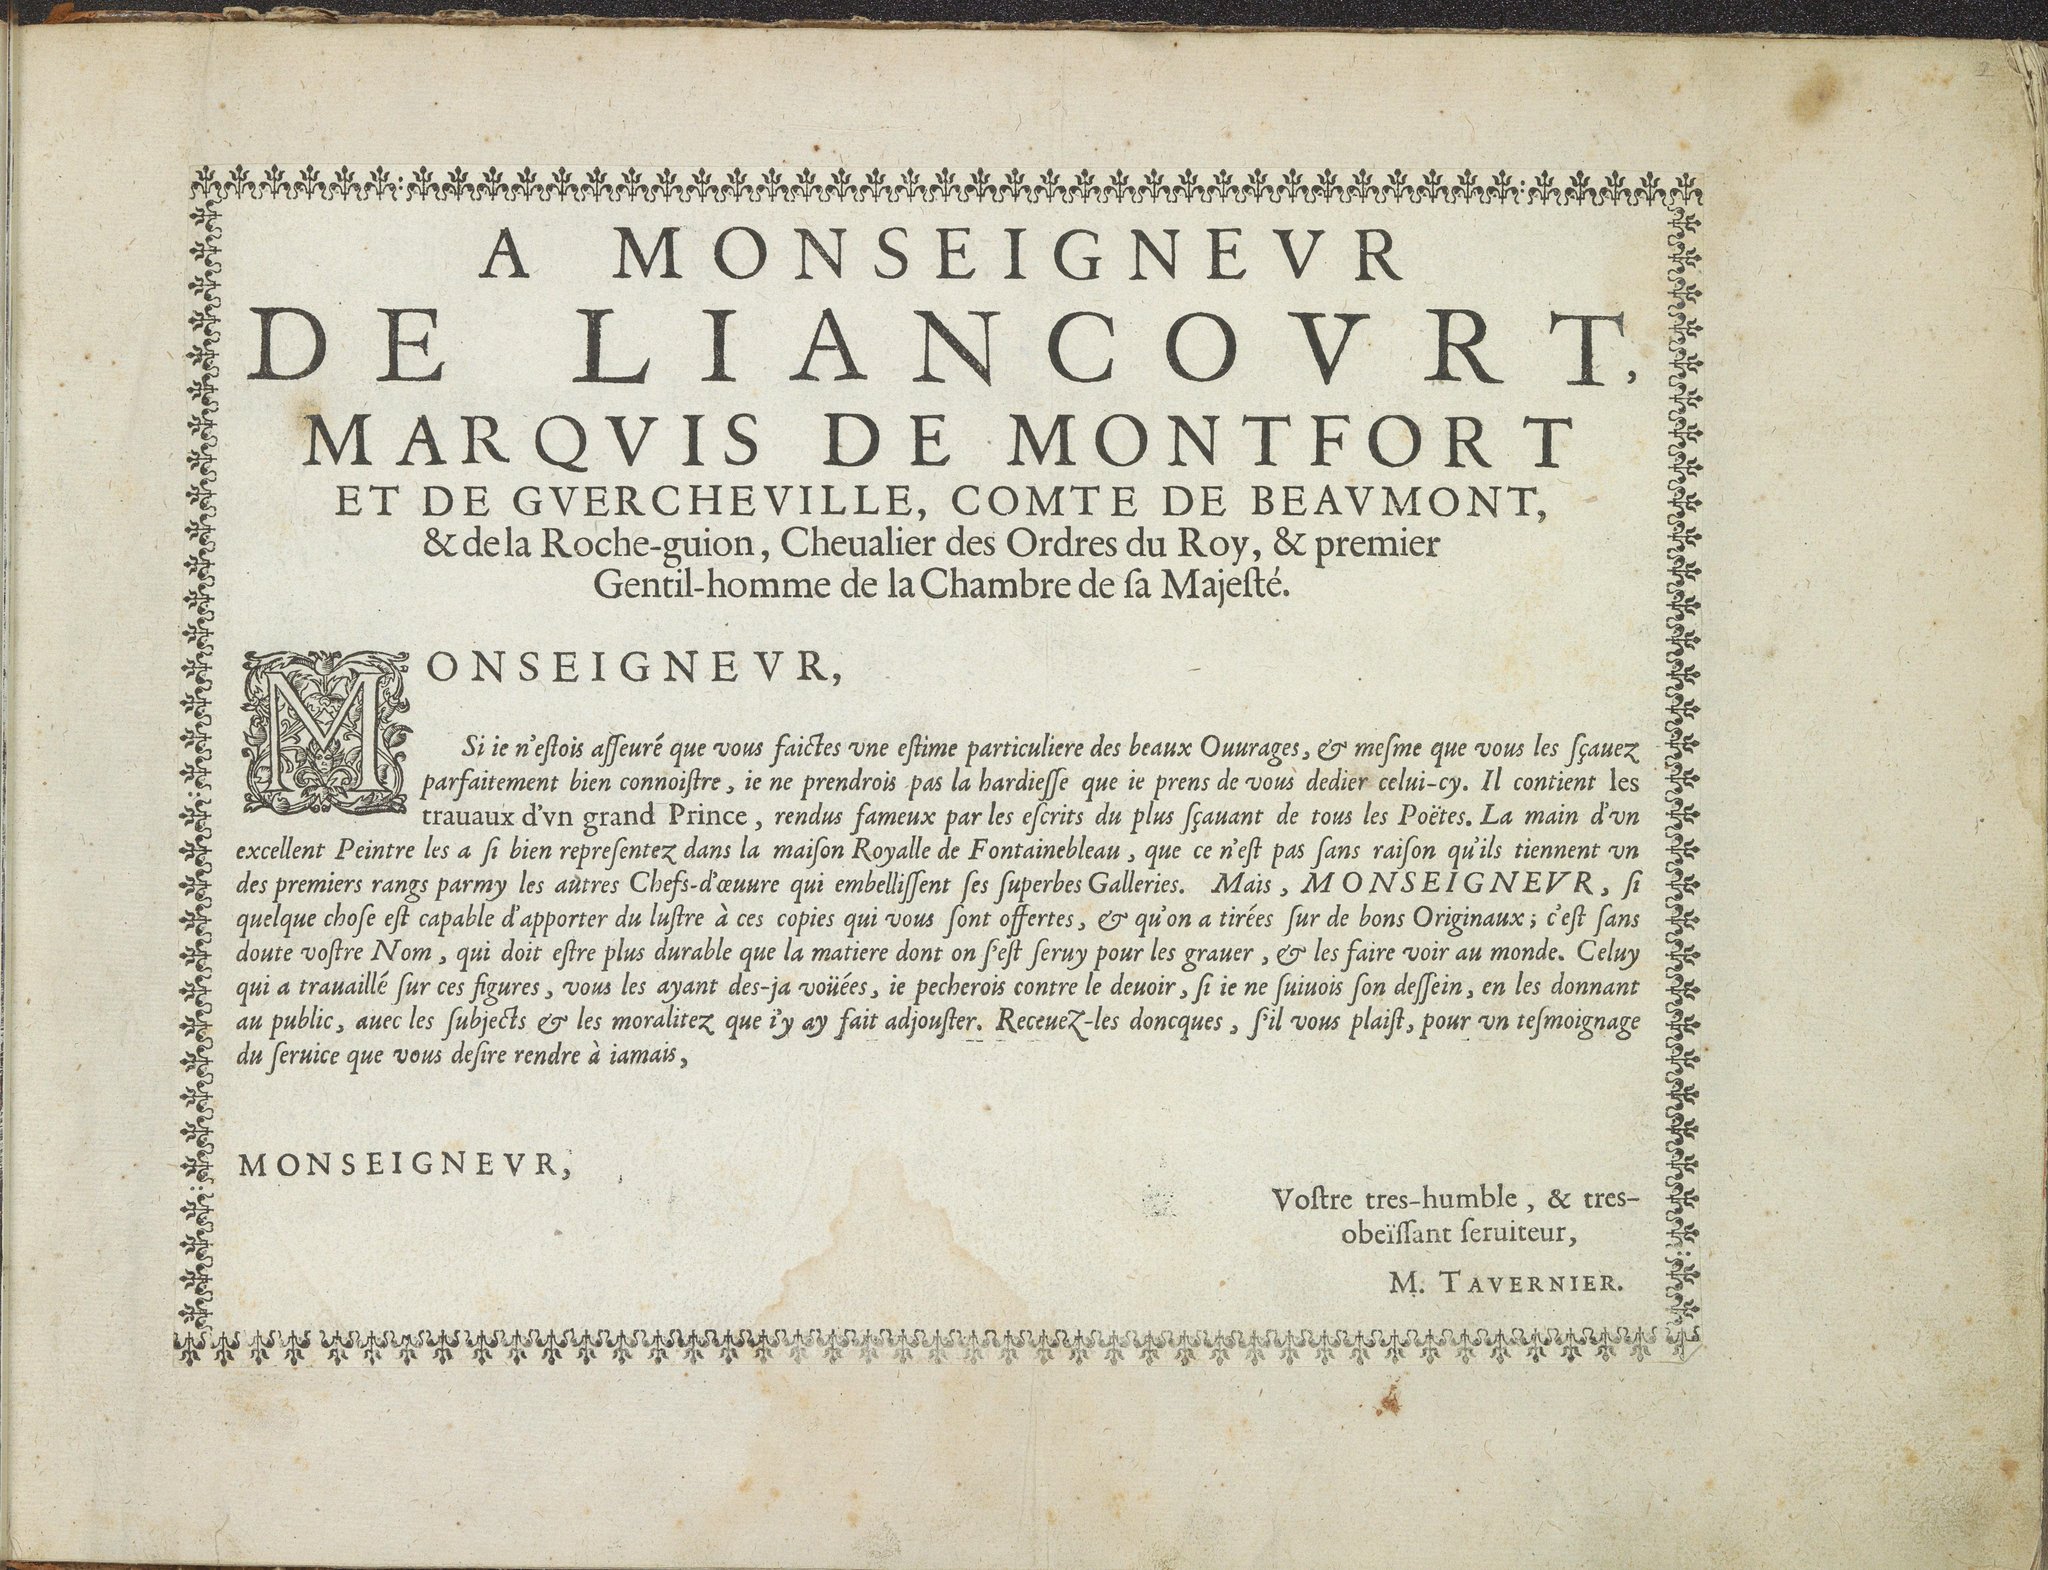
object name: text sheet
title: Les Travaux d'Ulysse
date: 1633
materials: paper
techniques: letterpress printing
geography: paris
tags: initial, title-page, ornamental decoration ~ printed matter, book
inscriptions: collector's mark: Lugt 2166, inscription: ‘Inventaris 1883 no 1235’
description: Dedicatie van de serie getiteld Les Travaux d'Ulysse aan Roger du Plessis, hertog van Liancourt. Ondertekend door Melchior Tavernier. De tekst begint met een gedecoreerde initiaal M. Met ornamentrand van fleurons. De pagina maakt deel uit van een album.